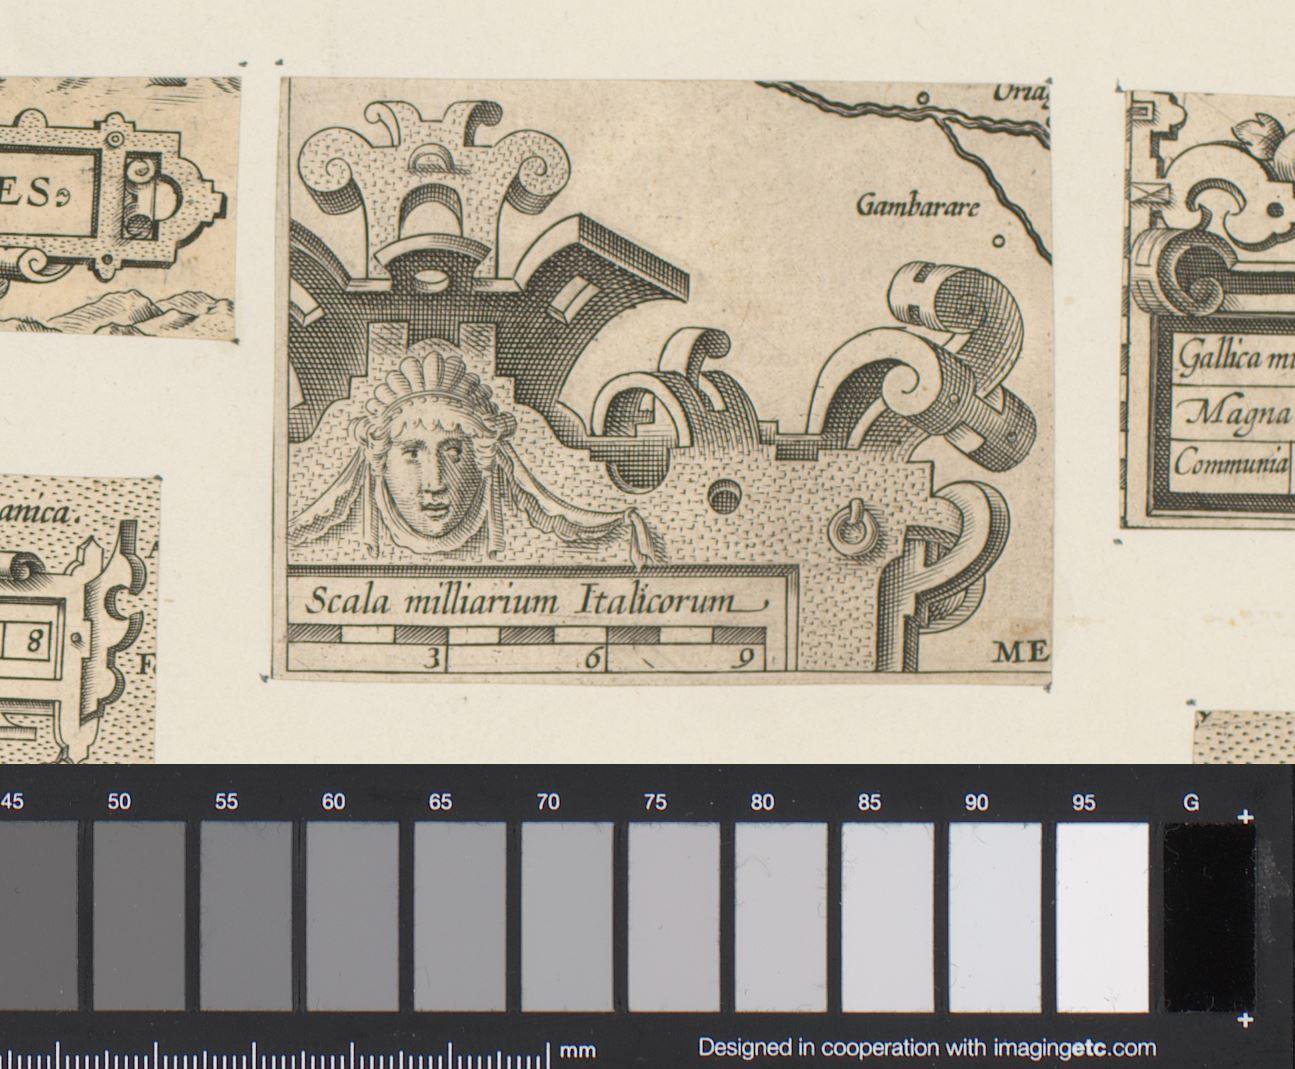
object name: ornament print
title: Theatrum Orbis Terrarum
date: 1595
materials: paper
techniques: engraving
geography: antwerp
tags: scrollwork, strapwork ~ ornament, ornament ~ cartouche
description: Hoekcartouche met mascaron en schaalstok (Scala milliarium Italicorum). De cartouche is een fragment van een kaart van Padua en Tarvisio. De prent maakt deel uit van een album.